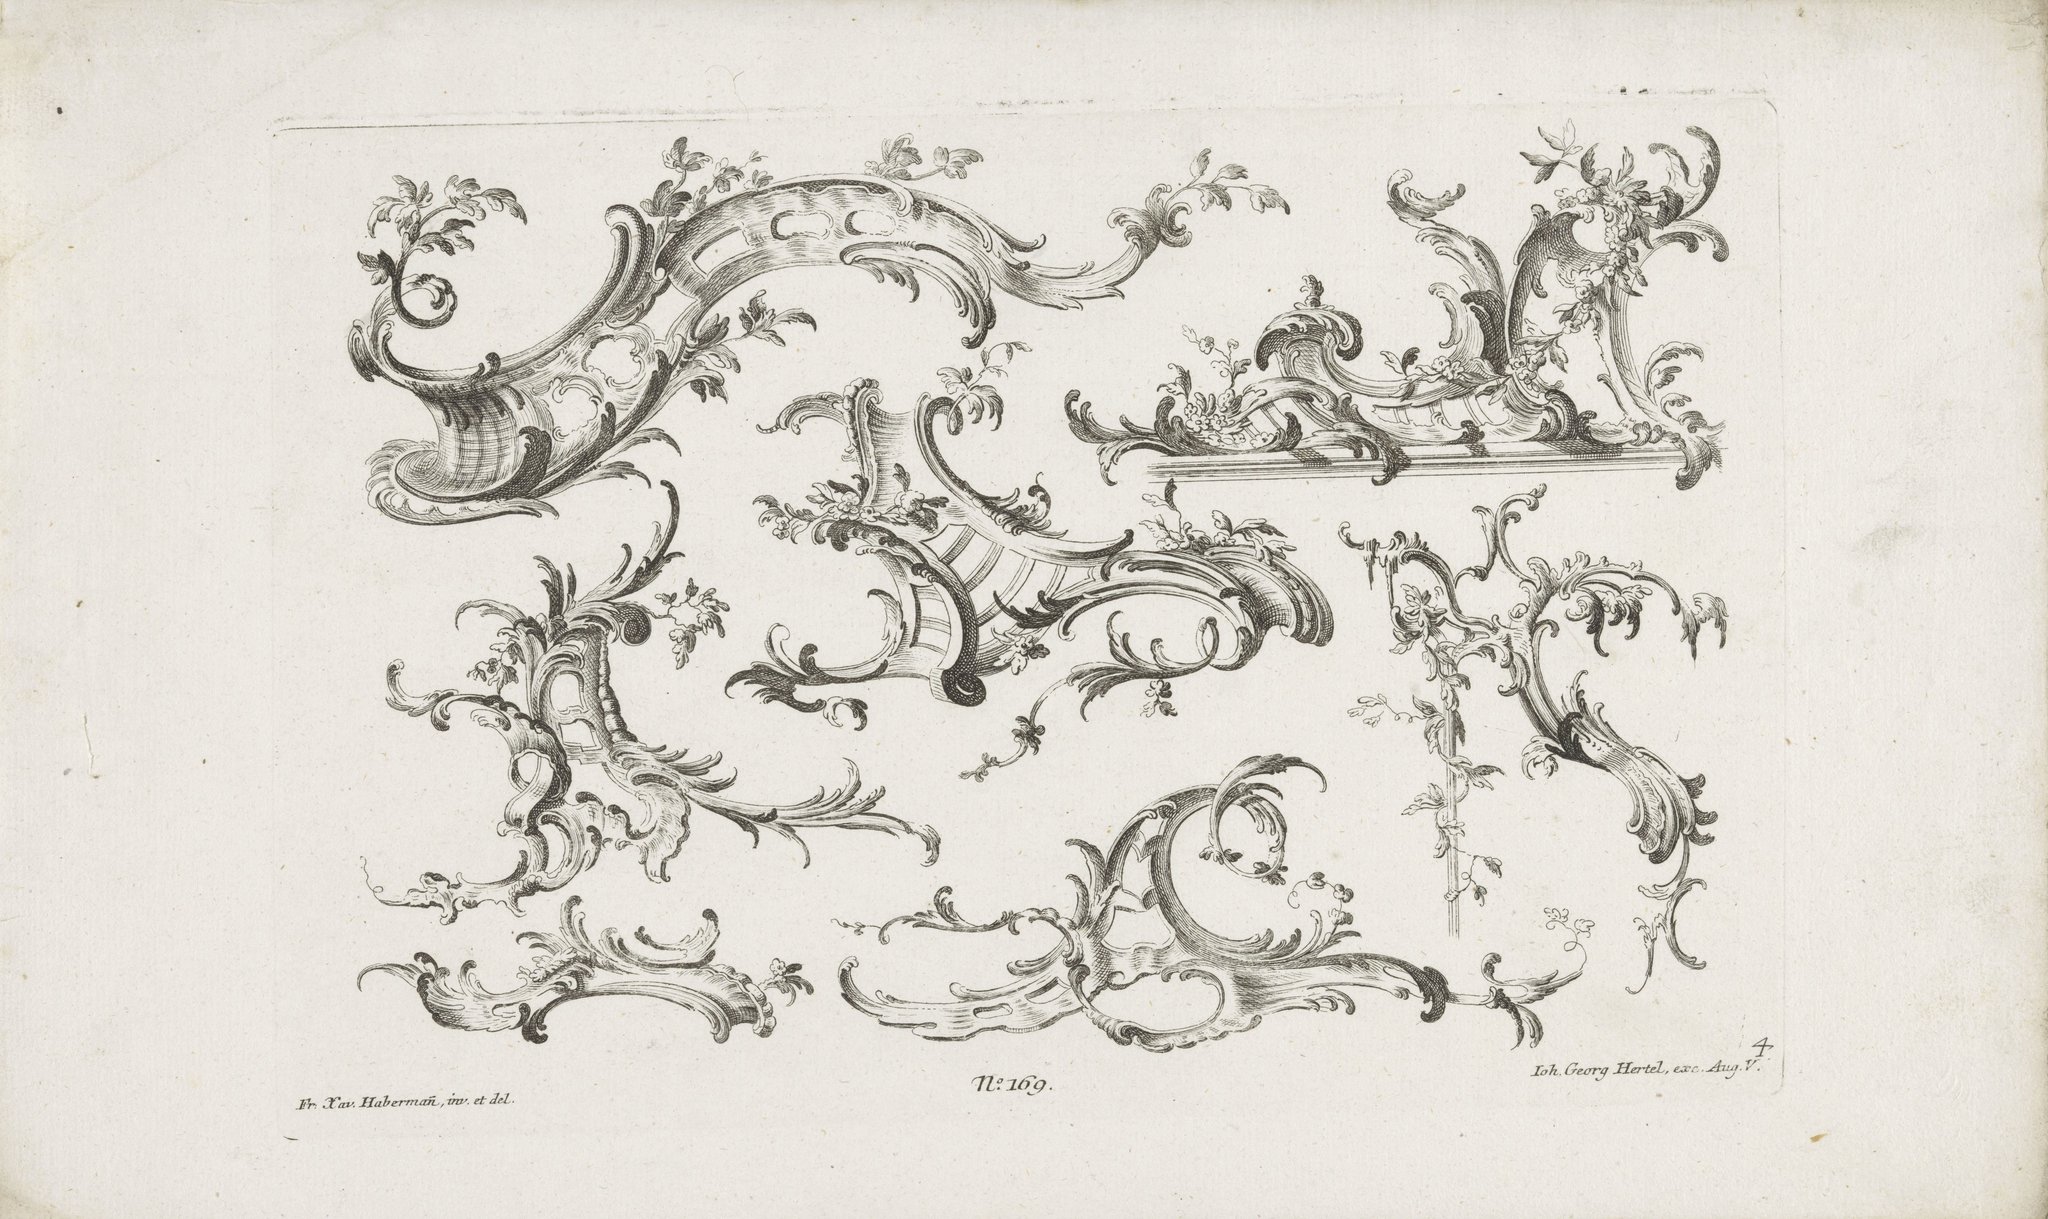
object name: print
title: Rocaille motieven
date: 1731-1775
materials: paper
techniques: etching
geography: augsburg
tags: rocaille ornament